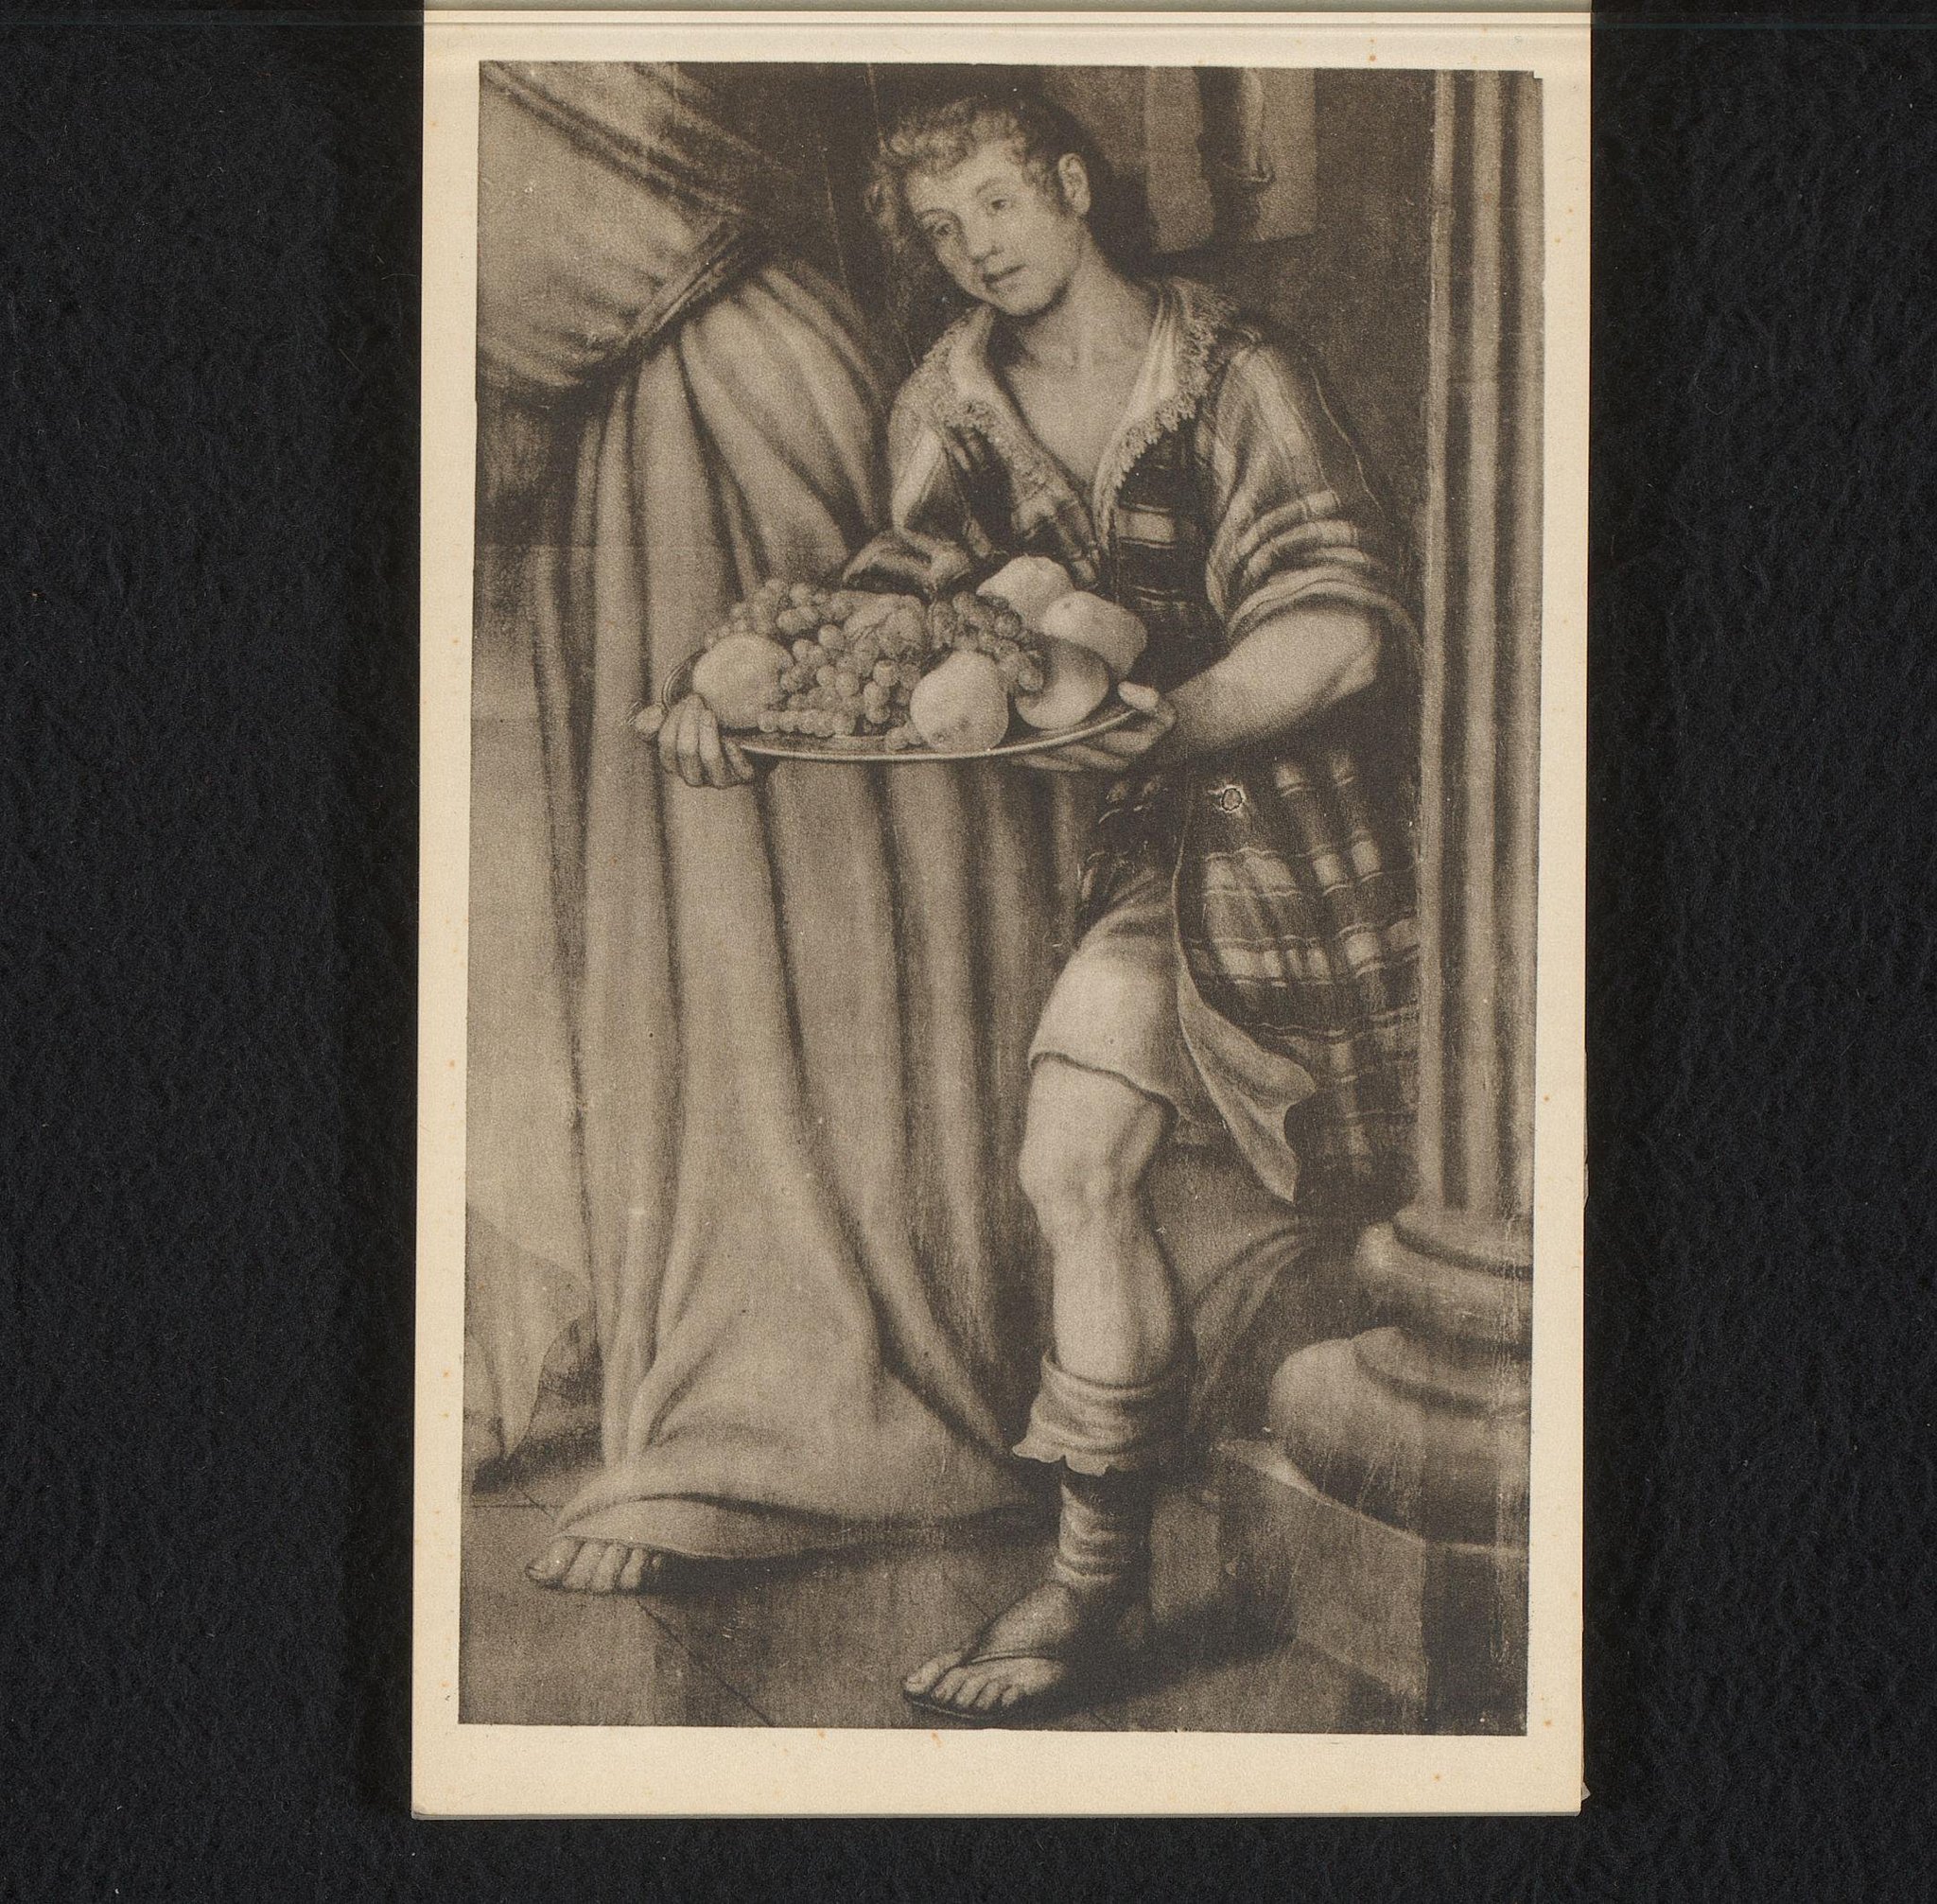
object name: photomechanical print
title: Museo Cerralbo. Madrid. Joven con una bandeja de frutas. Fragmento de la Sagrada Cena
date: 1924-1930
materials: cardboard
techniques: photograph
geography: madrid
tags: permanent exhibition, museum, picture, painting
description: Prentbriefkaart maakt deel uit van een album.